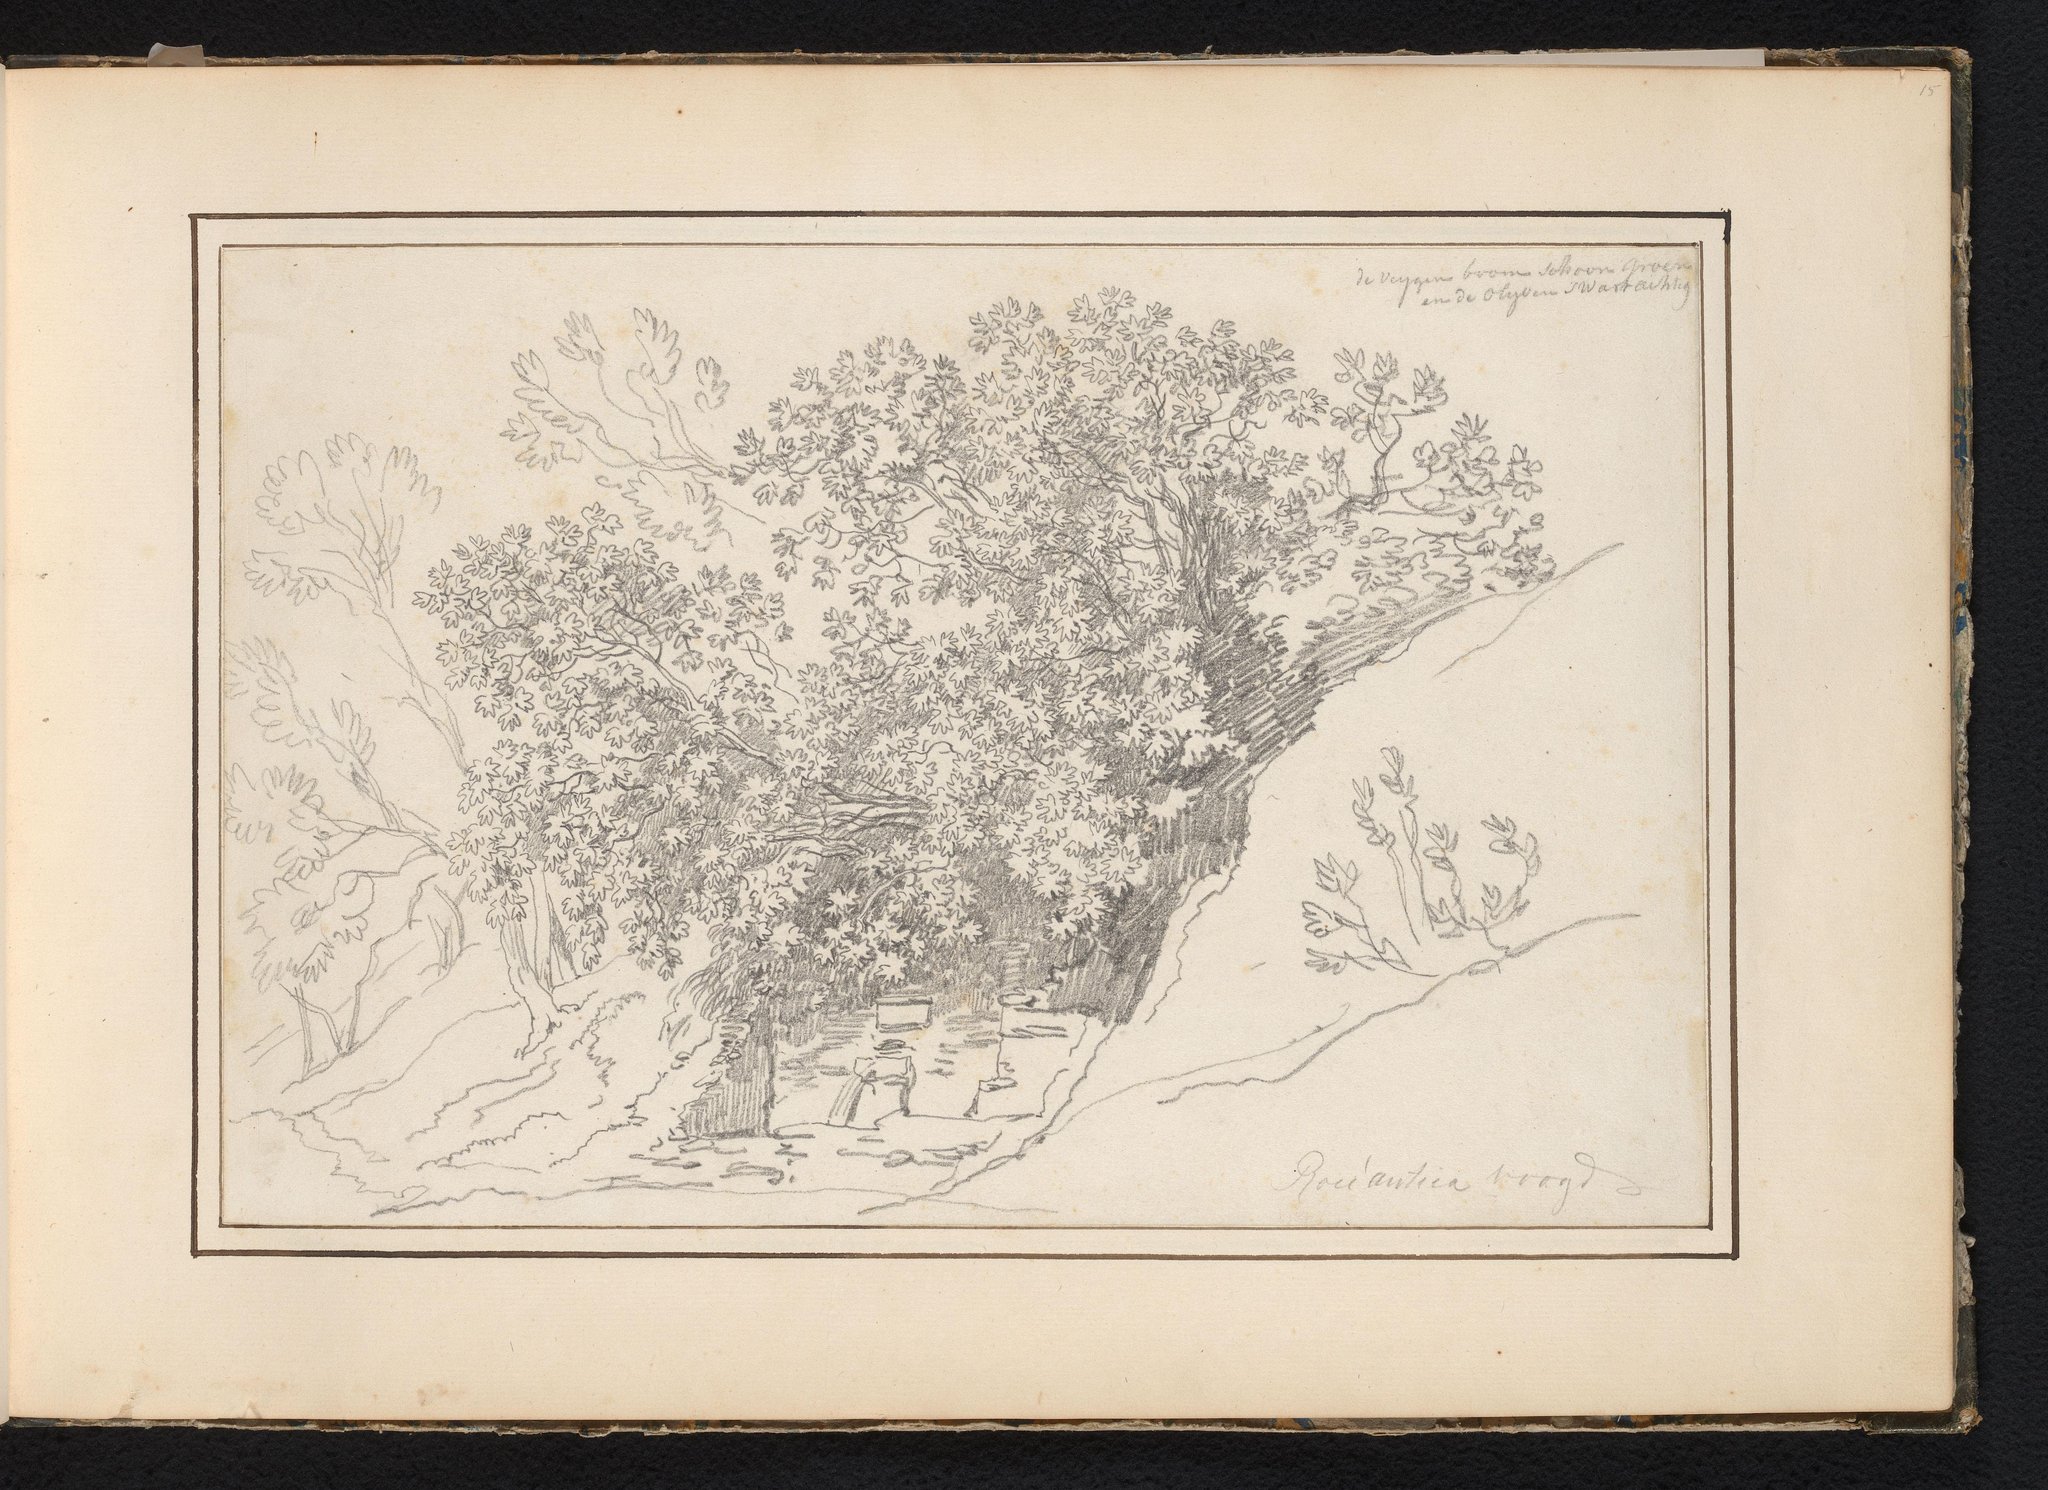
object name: album leaf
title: Vijgen- en olijvenboom te Roccantica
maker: hendrik voogd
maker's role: draughtsman, painter, print maker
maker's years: 1768-1839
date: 1788-1839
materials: paper, pencil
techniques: pasting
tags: trees: fig-tree, trees: olive-tree, roccantica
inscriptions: inscription: ‘Rocc'antica’, inscription: ‘de vygenboom schoon groen en de olijven zwartachtig’